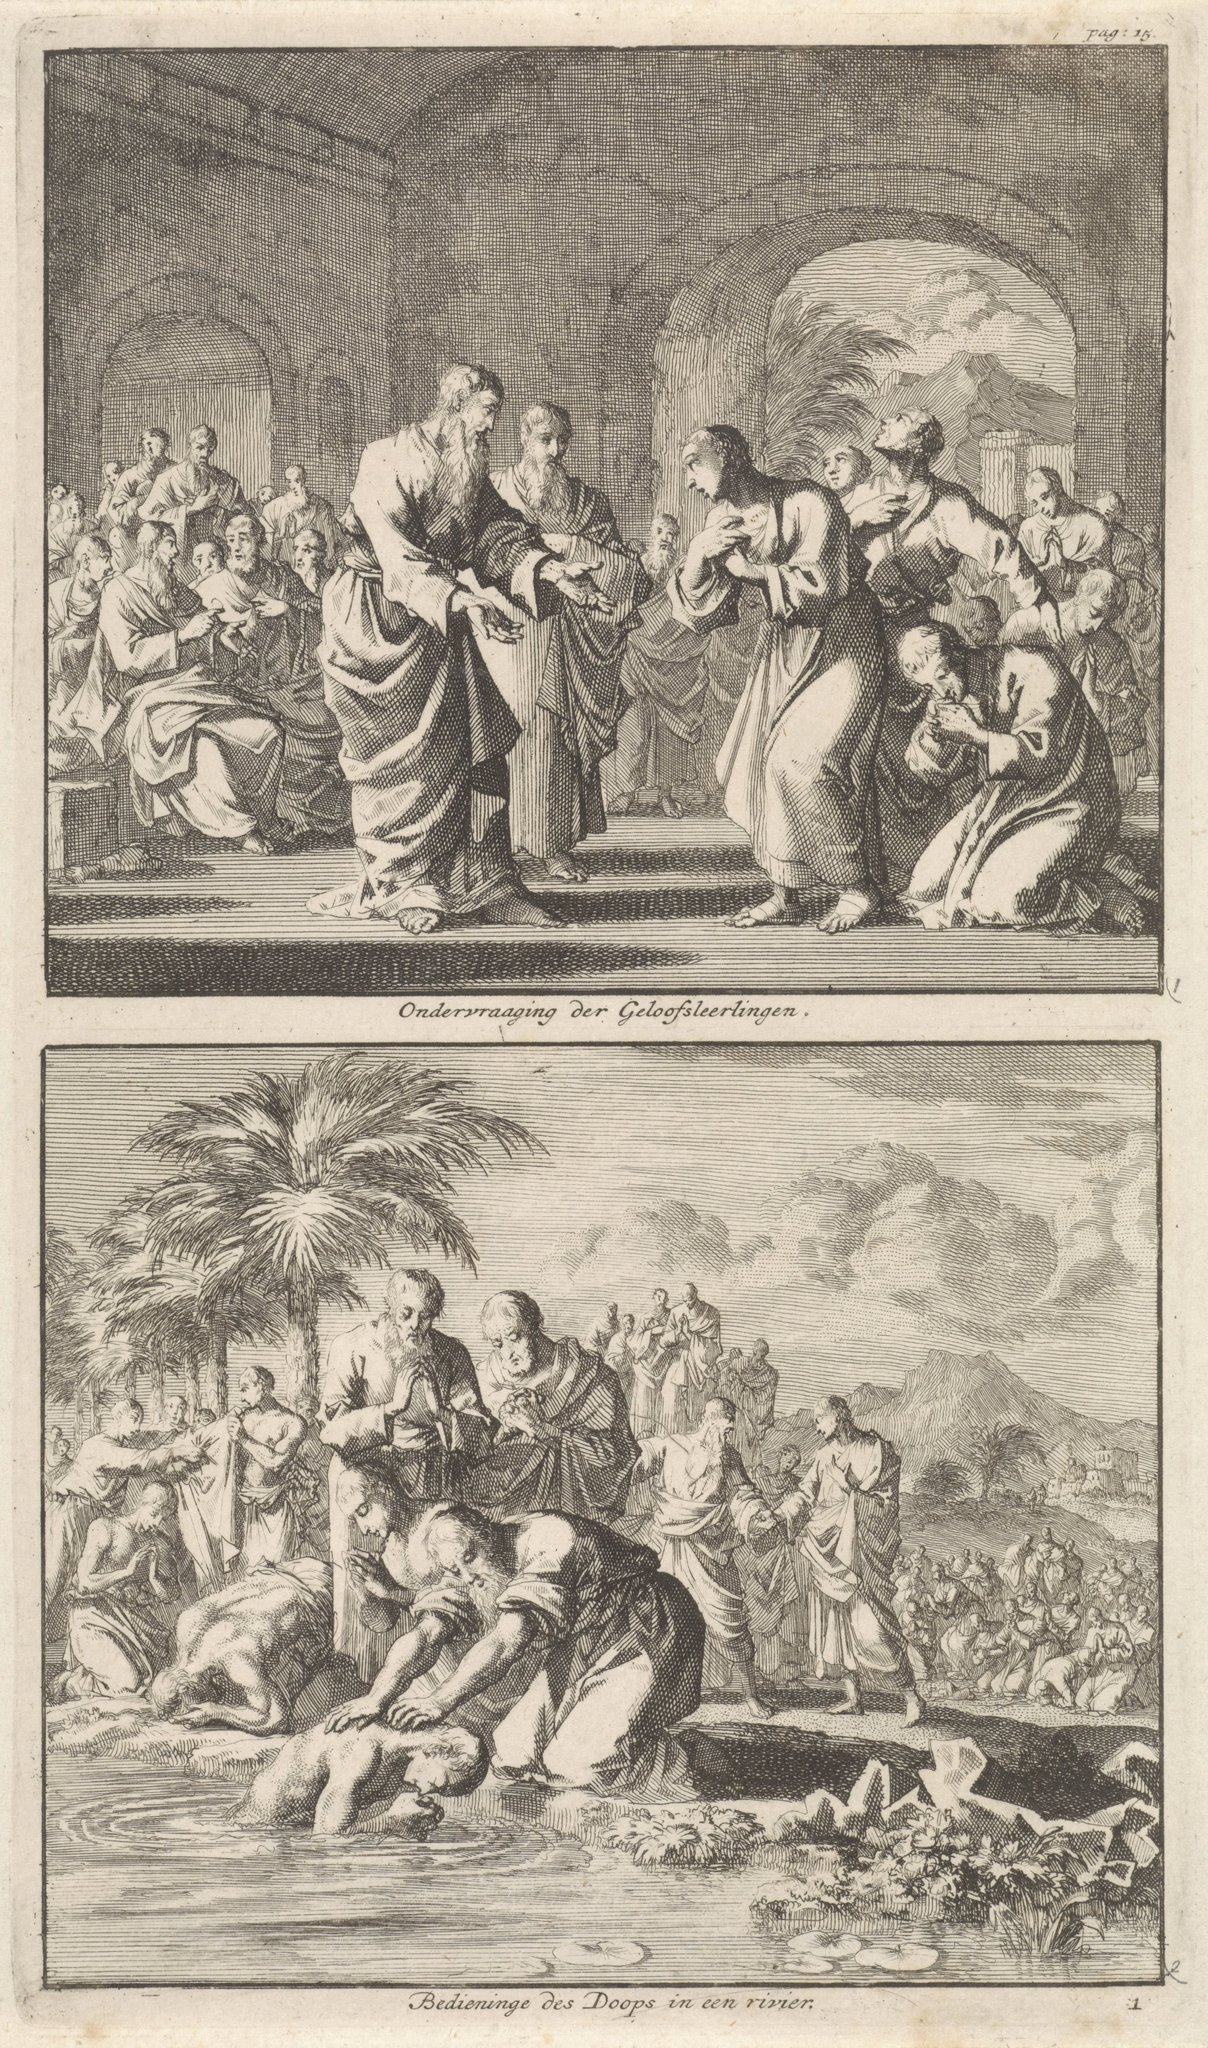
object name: book illustration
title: Ondervraaging der Geloofsleerlingen / Bedieninge des Doops in een rivier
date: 1700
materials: paper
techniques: etching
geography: amsterdam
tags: catechism, the early christian churches, e.g. armenians, copts, syrians, disciples preaching and baptizing (in general), community of disciples (preaching, healing, etc. in general) (acts 2:42-47, 4:32 - 5:11), creed, credo, religious instruction of laity, e.g. sunday school, baptism, christening ceremony ~ the first of the seven sacraments - qq - baptism in the open air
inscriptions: collector's mark: Lugt 2228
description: Twee voorstellingen op een plaat. Boven: op de voorgrond een leraar die vijf nieuwe gelovigen ondervraagt over de verschillende artikelen van het geloof. Op de achtergrond de gemeente der gelovigen. Onder: nieuwe gelovigen worden in een rivier gedoopt door de leerlingen van Christus. Langs de oever van de rivier de gemeenschap der christenen.